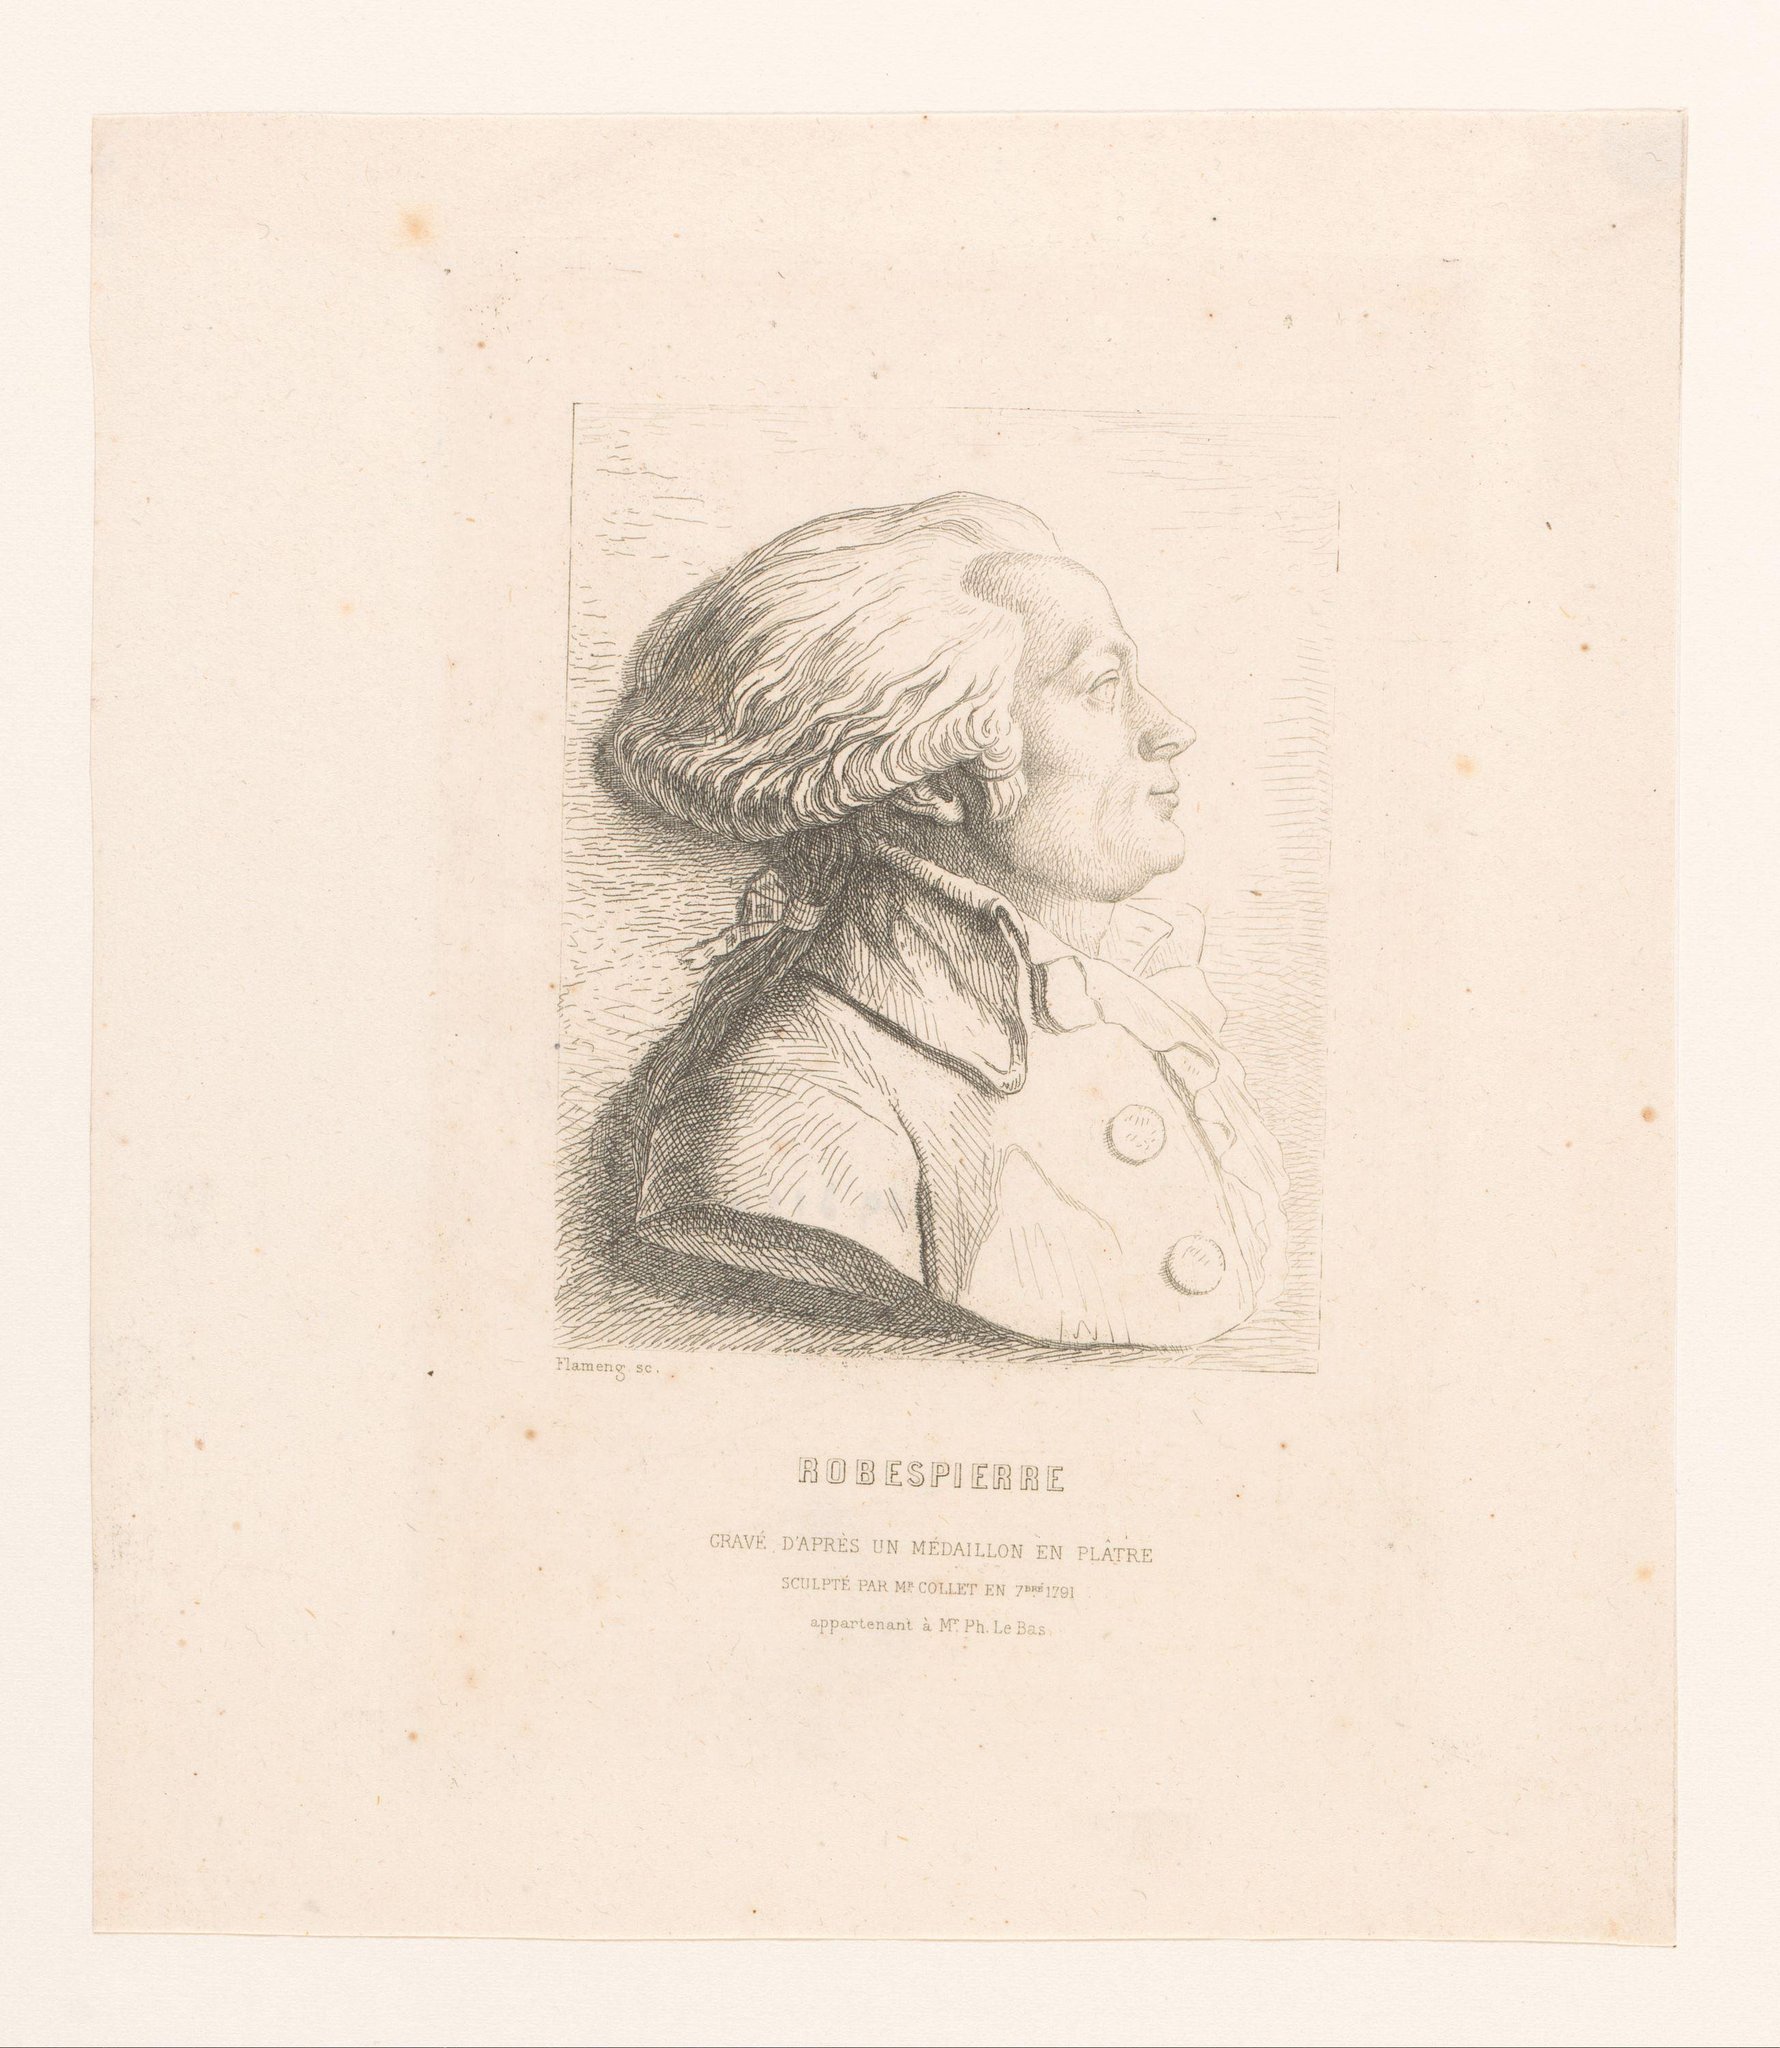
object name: print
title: Robespierre gravé d'après un médaillon en platre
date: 1841-1910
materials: paper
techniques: etching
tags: historical persons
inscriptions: collector's mark: Lugt 2228